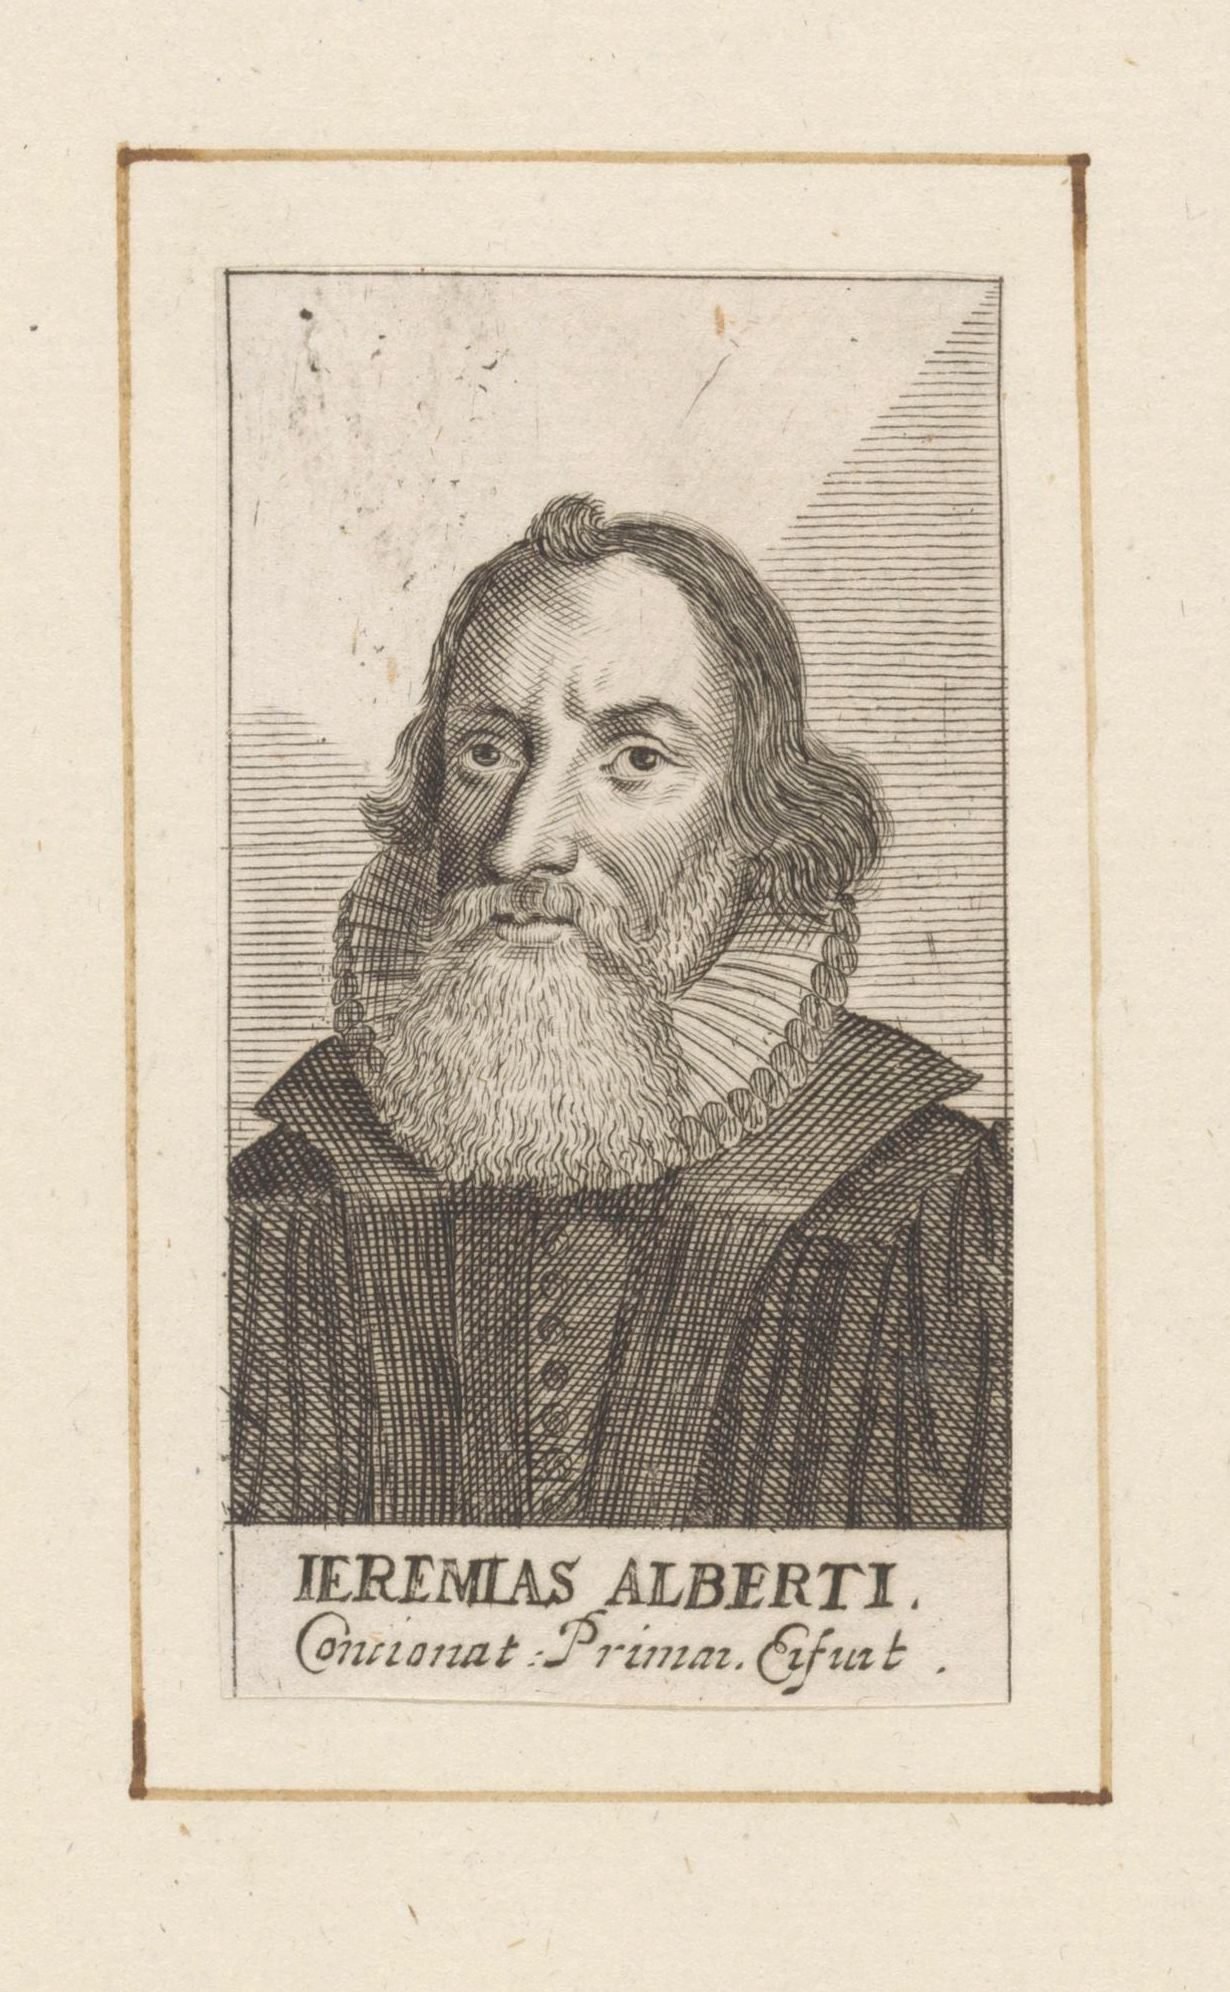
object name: print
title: Portret van Jeremias Alberti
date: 1688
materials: paper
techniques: engraving, etching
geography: nuremberg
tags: erfurt, jeremias alberti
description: Prent uit: Freher, Paul. Theatrum virorum eruditione clarorum. Neurenberg: Johann Hoffmann, 1688.